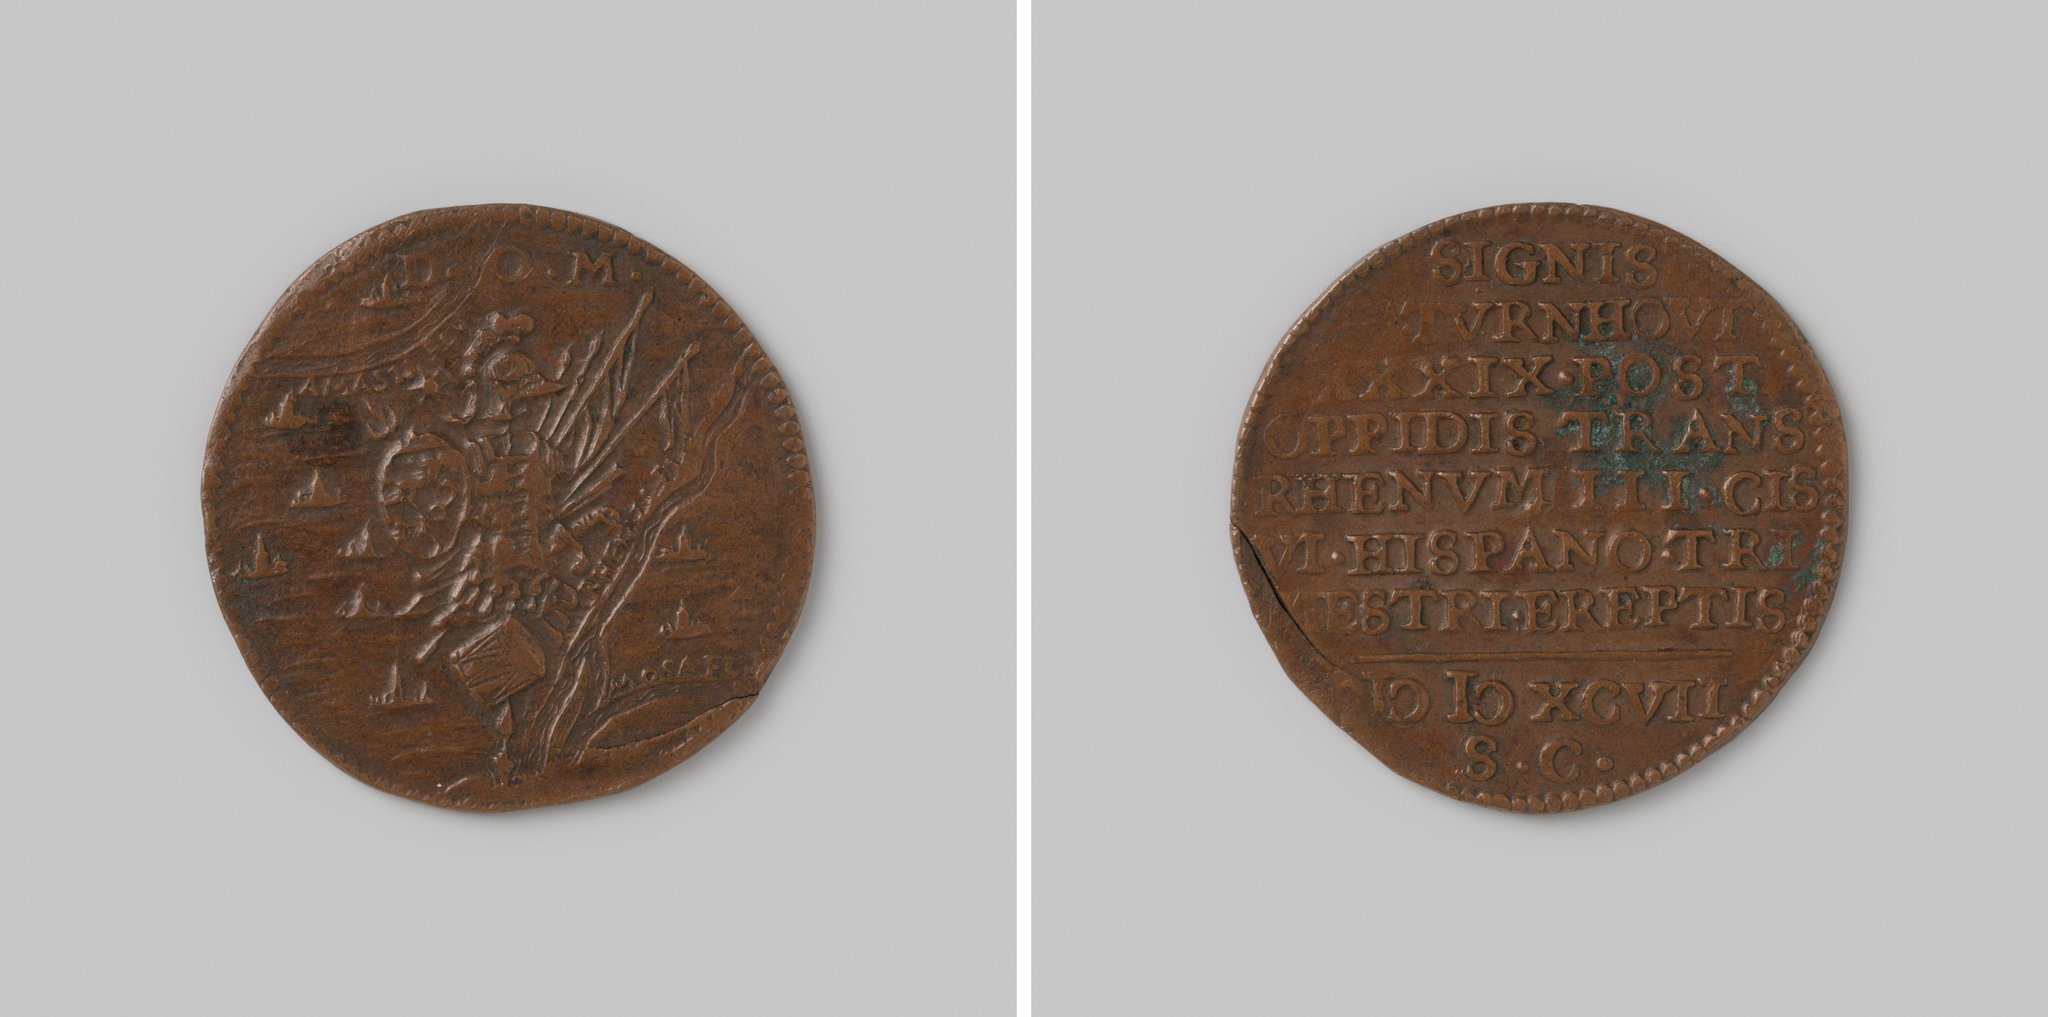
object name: jeton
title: Rekenpenning op de overwinning in de Slag bij bij Turnhout 1597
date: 1597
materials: copper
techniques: striking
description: Koperen penning, op de voorzijde een wapentrofee op een landkaart, met tekst, op de keerzijde negen regels tekst.